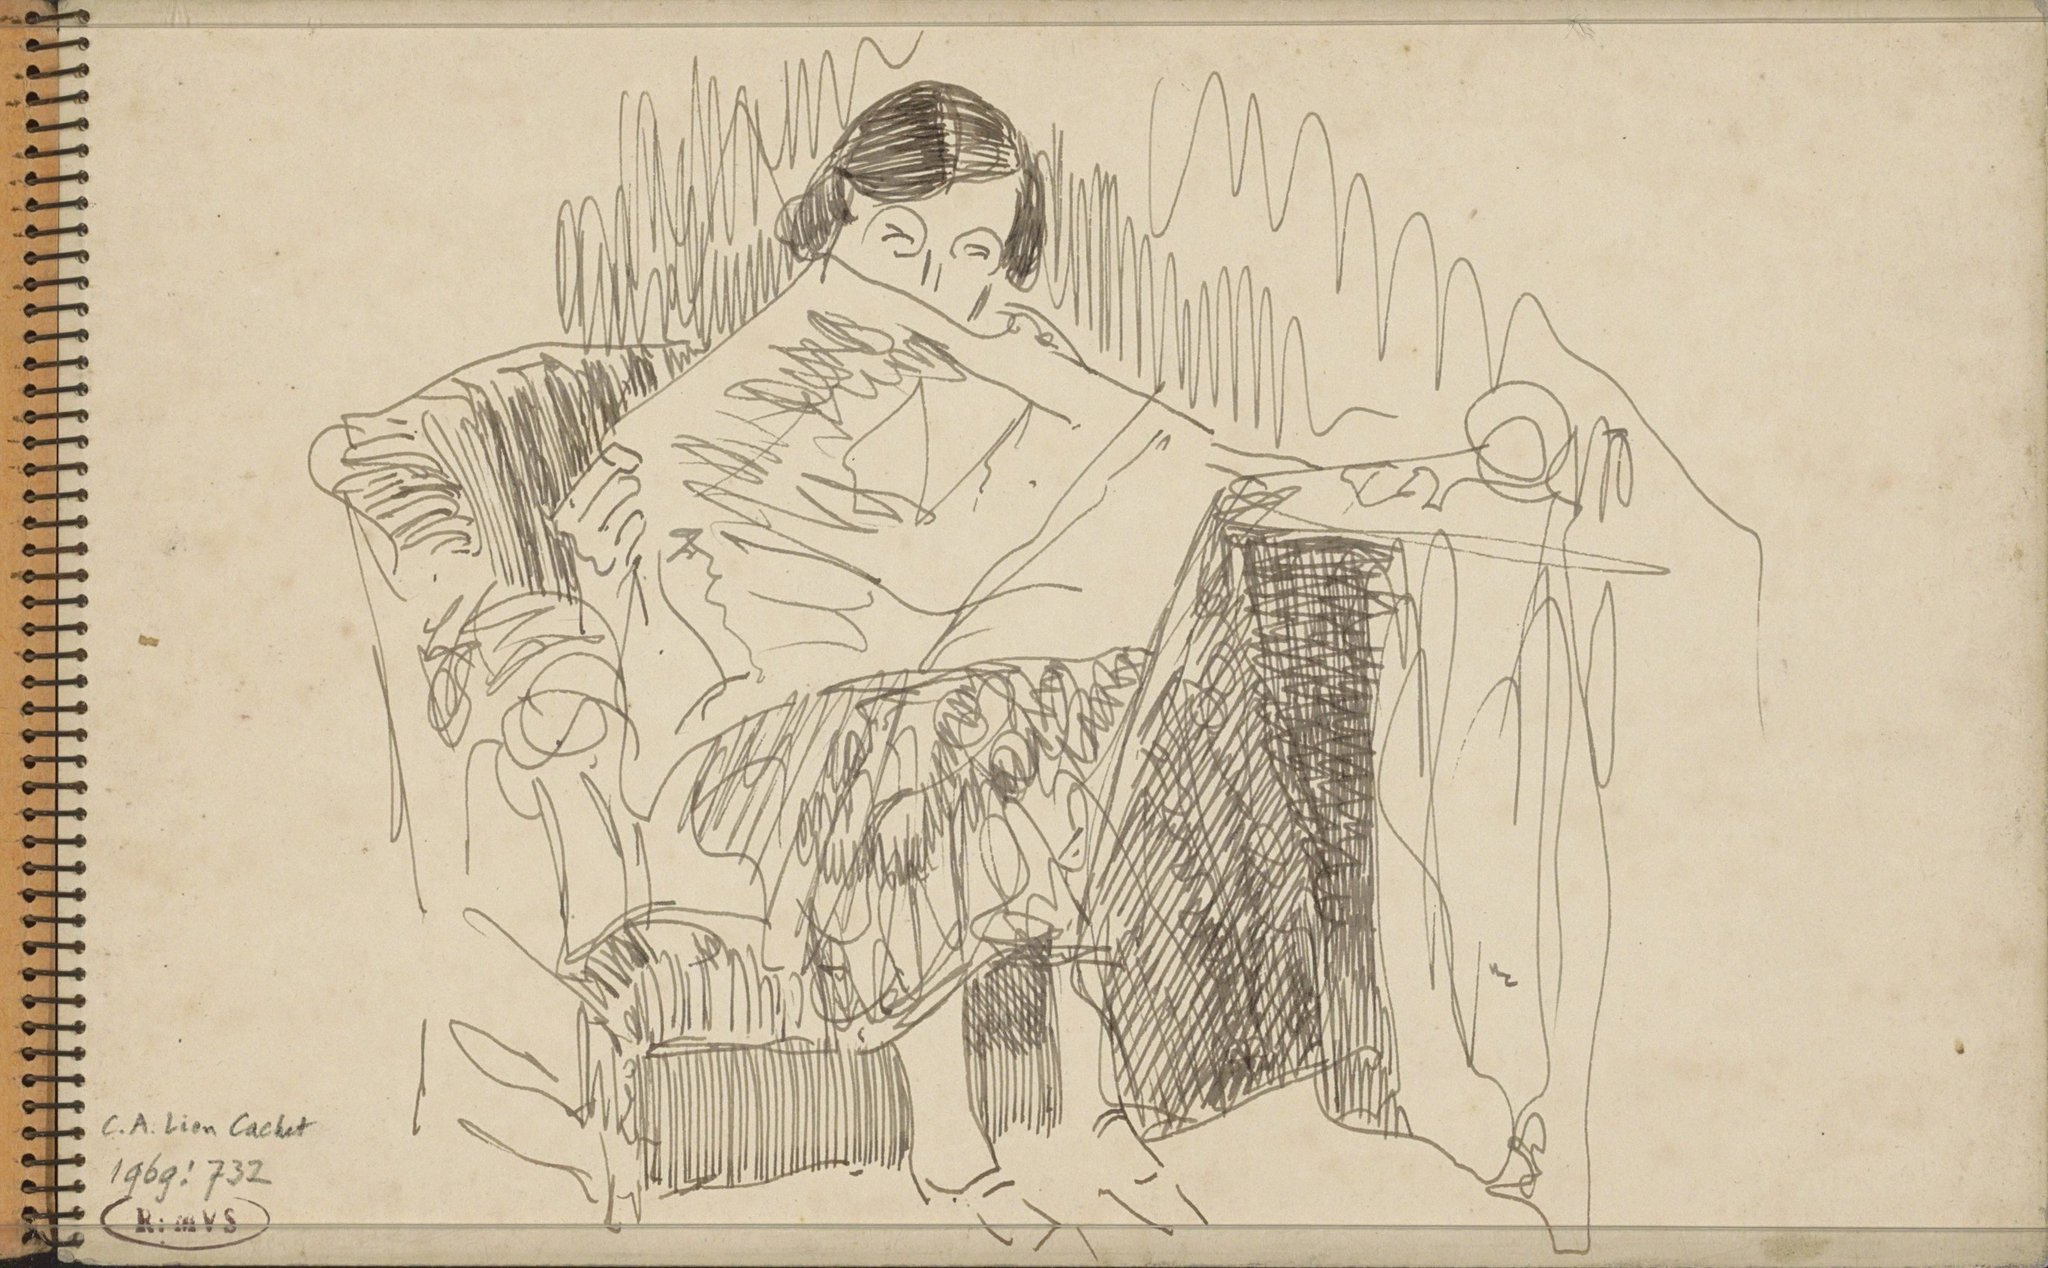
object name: sketchbook leaf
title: Vrouw die een krant leest in een leunstoel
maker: carel adolph lion cachet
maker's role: draughtsman, print maker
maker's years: 1864-1945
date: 1930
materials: ink, paper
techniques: pen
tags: reading, sitting figure (+ adult female (human being)), newspaper, news-sheet, chair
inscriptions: collector's mark: Lugt 2228a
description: Blad 1 recto uit een schetsboek met 14 bladen.